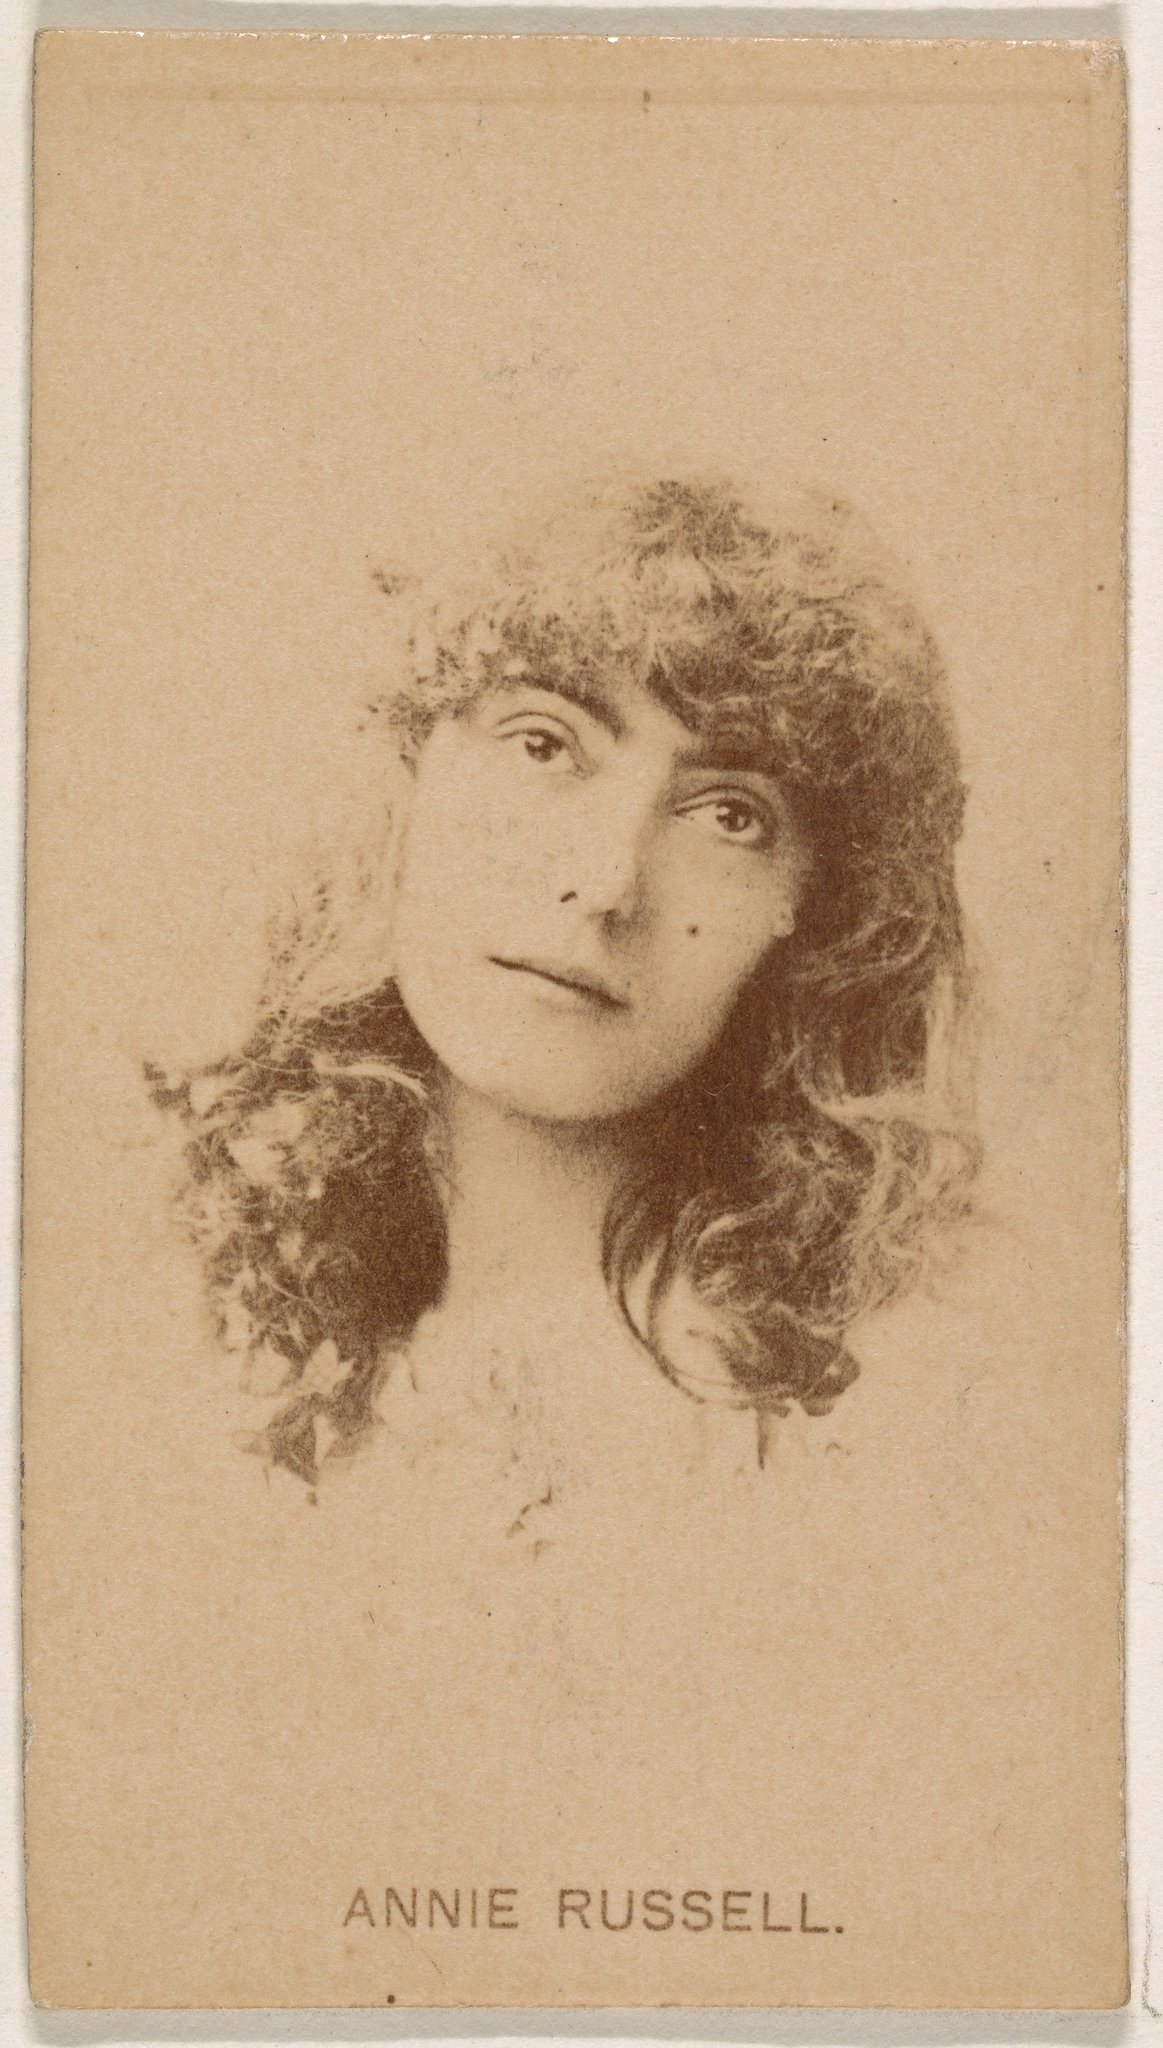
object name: photograph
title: Annie Russell, from the Actresses series (N245) issued by Kinney Brothers to promote Sweet Caporal Cigarettes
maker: kinney brothers tobacco company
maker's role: publisher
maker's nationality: american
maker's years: 1869-2011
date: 1890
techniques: albumen silver print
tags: portraits,women,actresses